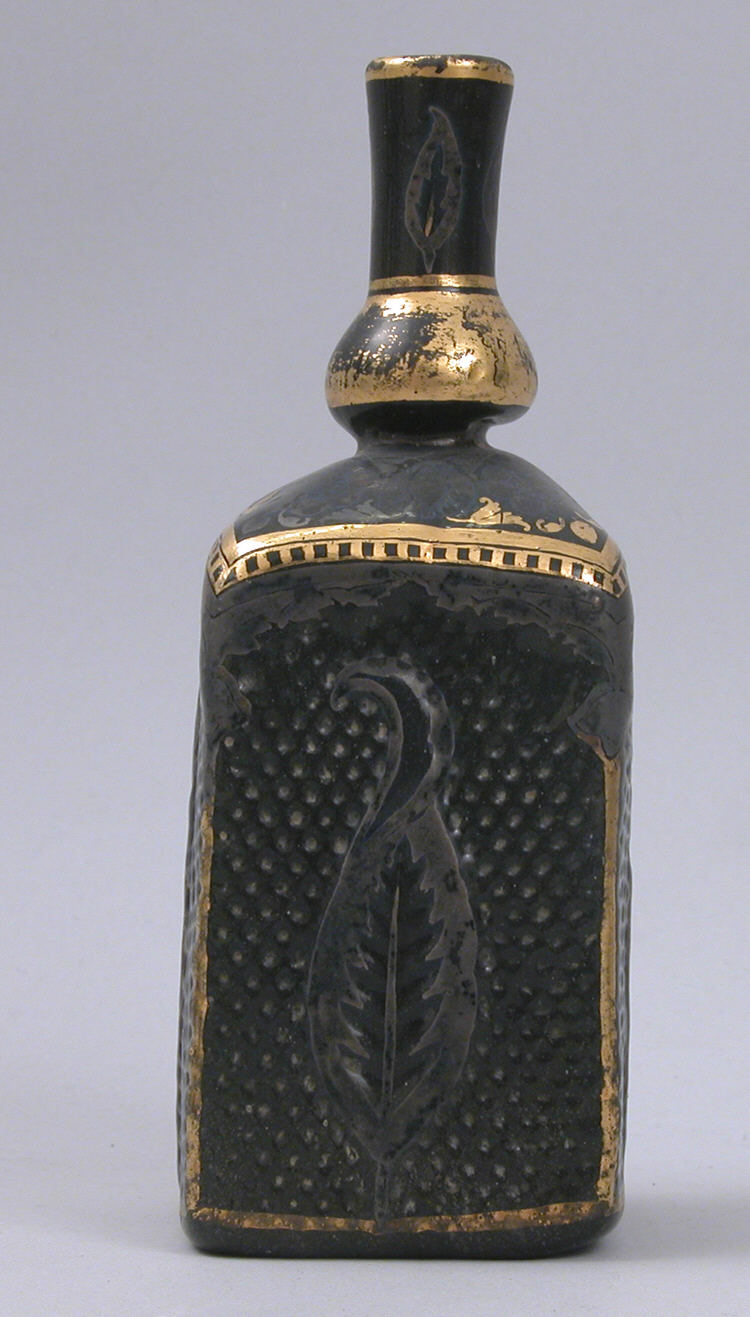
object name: bottle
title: Gilded Green Bottle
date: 1701-1800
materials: glass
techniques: glassblowing, gilding, silvered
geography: northern india